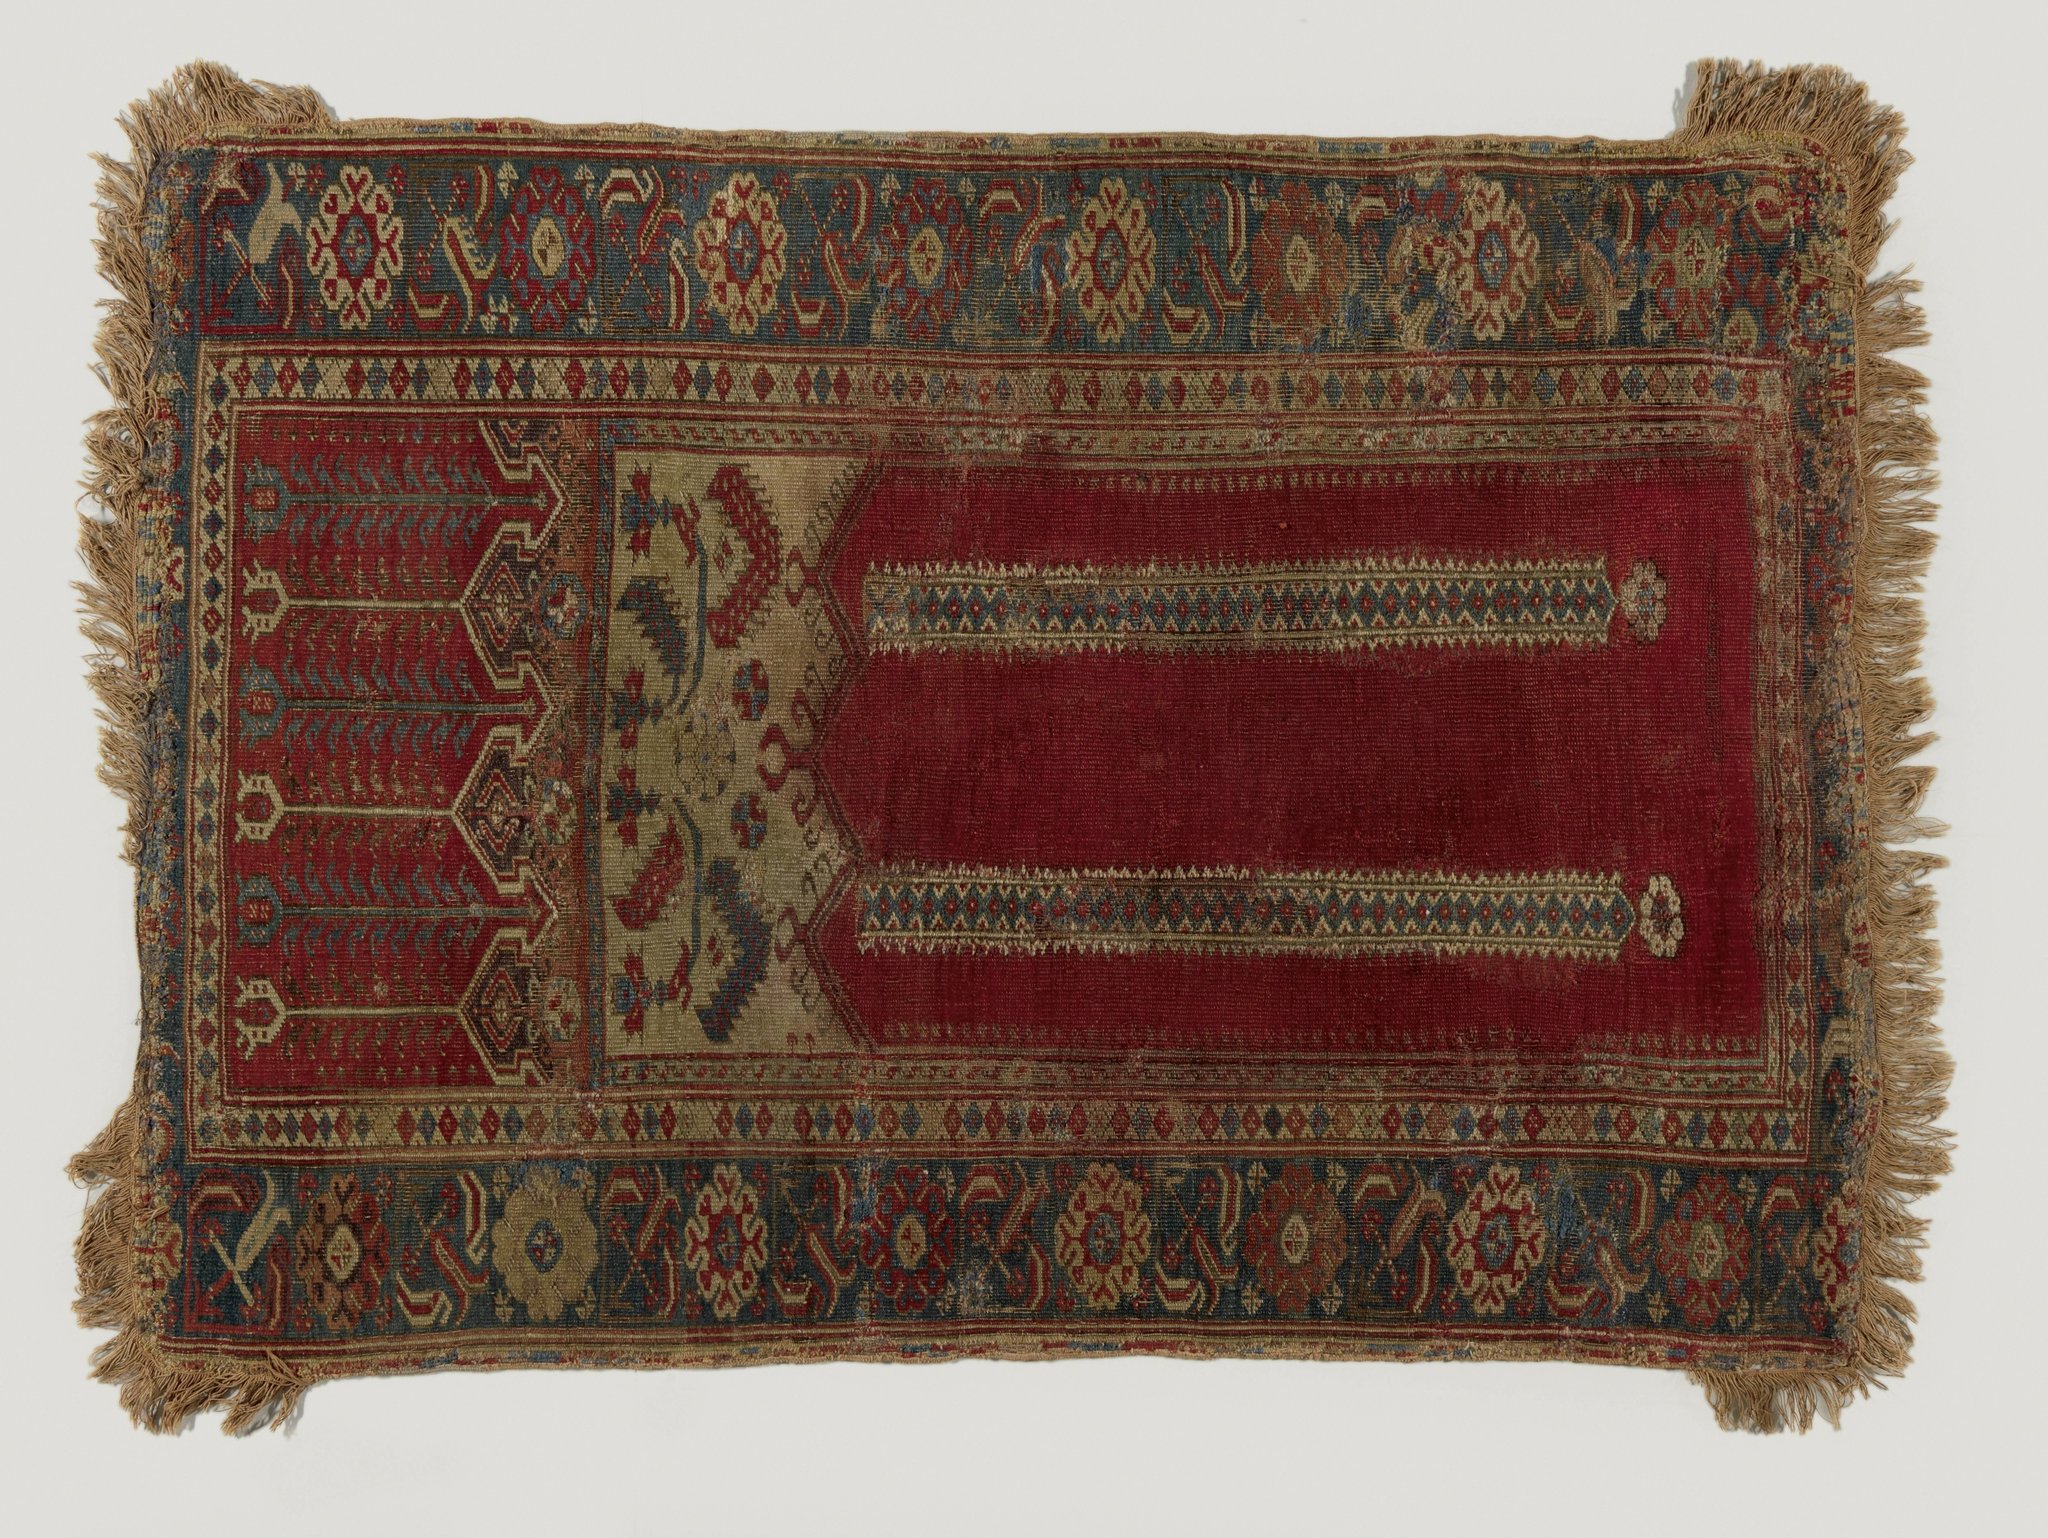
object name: oriental rug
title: Bidkleed met bovendwarspanelen, LADIK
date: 1800-1850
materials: wool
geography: ladik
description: Bidkleed met bovendwarspanelen, LADIK. Middenveld: steenrode mihrab met drie even hoge rechtlijnige topgevels, gesteund door twee zwevende kolommen. De witte zwikken zijn verhoogd met een roze dwarspaneel, met wit/paarse omega-band, overgaand in een rood dwarspaneel met afwisselend blauwe en witt tulpen. Randen: drievoudig. De hoofdrand is kobaltblauw, waarop gedrongen ruitrozetten in rood en wit staan tussen schuinstaande tulpen in roze, rood en wit. Franje: aangenaaide, katoenen franje in bleek roze-geel, die om de hoeken ca. 12 cm. doorlopen aan de zijranden.